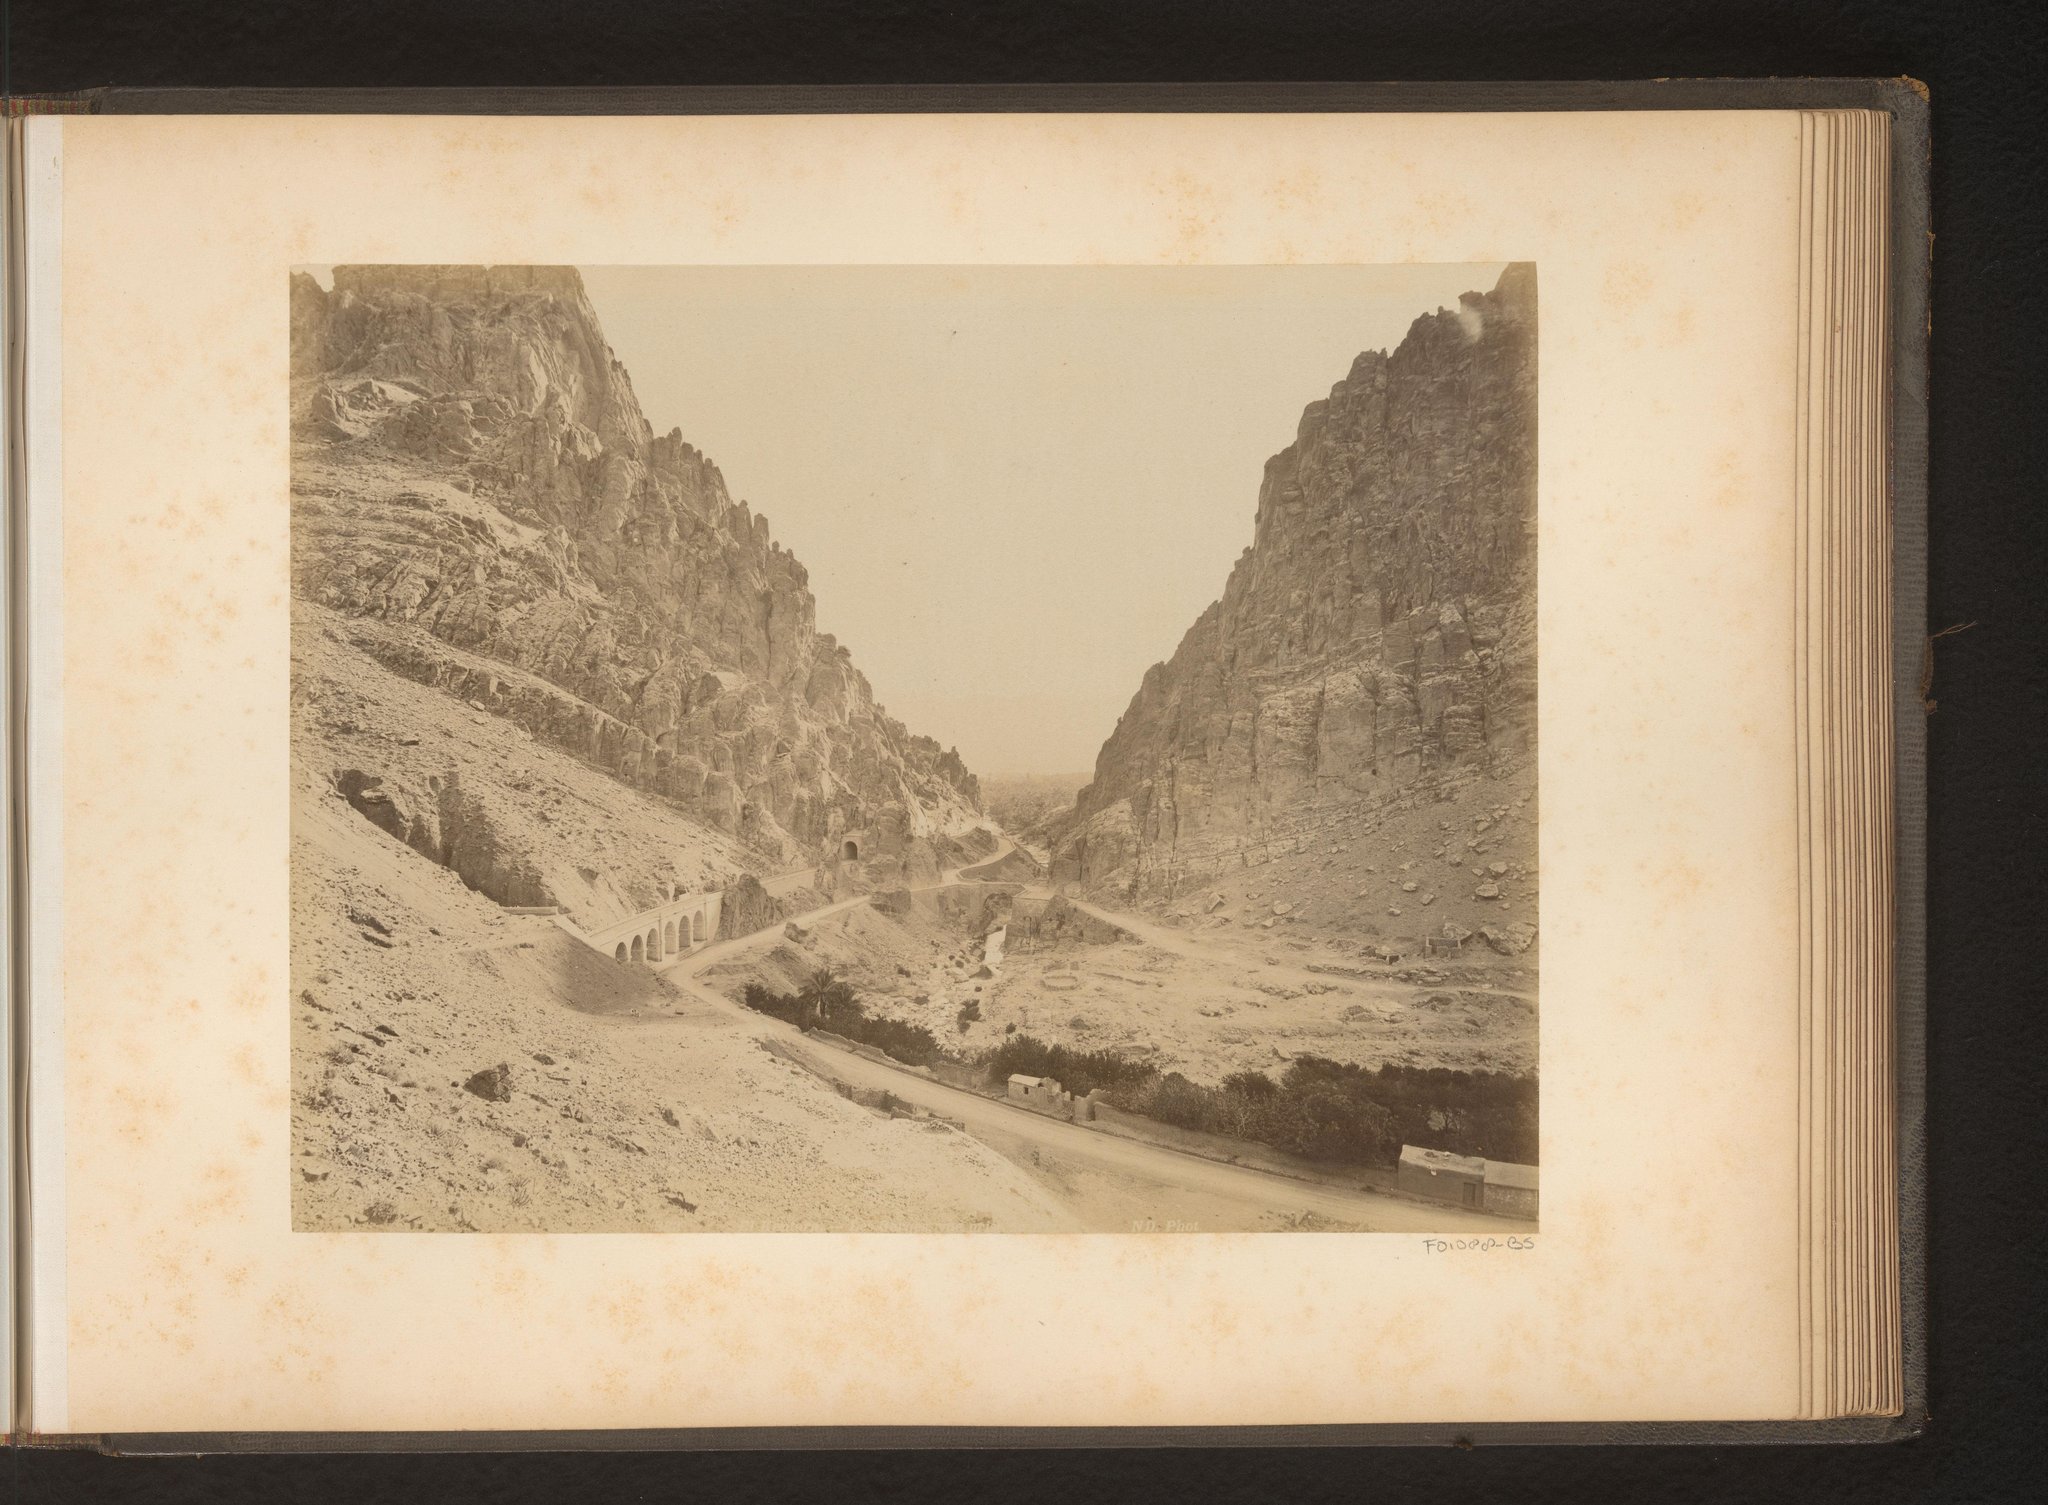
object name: album leaf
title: Gezicht op een kloof in de omgeving van El Kantara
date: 1880-1900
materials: photographic support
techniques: albumen print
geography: algeria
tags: ravine, chasm, abyss, canyon - hh - ideal landscapes, underground road, tunnel, public road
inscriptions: number: ‘380’, check stamp: ‘J. Kuhn Editeur/ 220 Rue de Rivoli Paris’